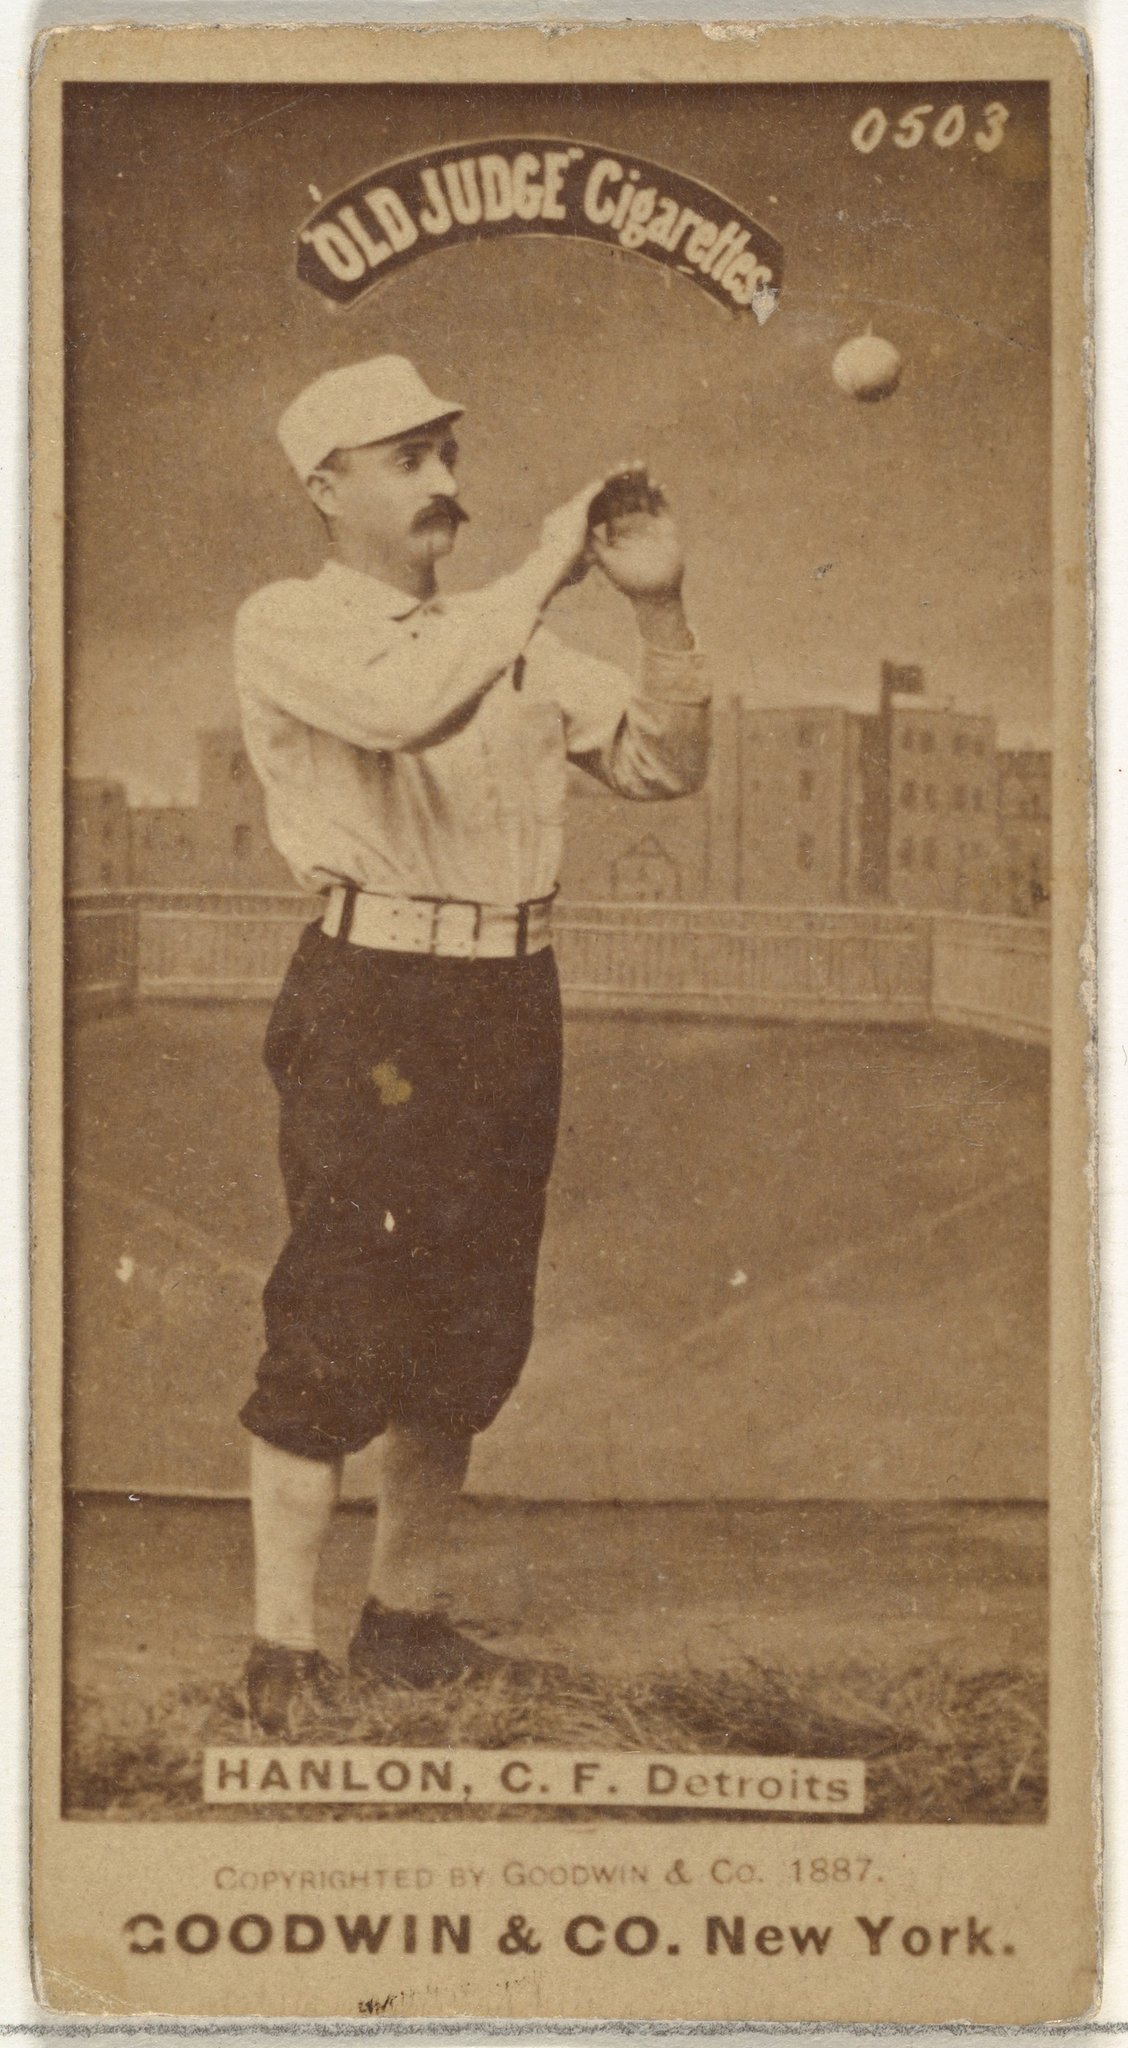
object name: baseball card, photograph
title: Edward Hugh "Ned" Hanlon, Center Field, Detroit Wolverines, from the Old Judge series (N172) for Old Judge Cigarettes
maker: goodwin & company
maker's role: publisher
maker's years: 1850-1950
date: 1887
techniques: albumen silver print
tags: men,portraits,baseball,athletes